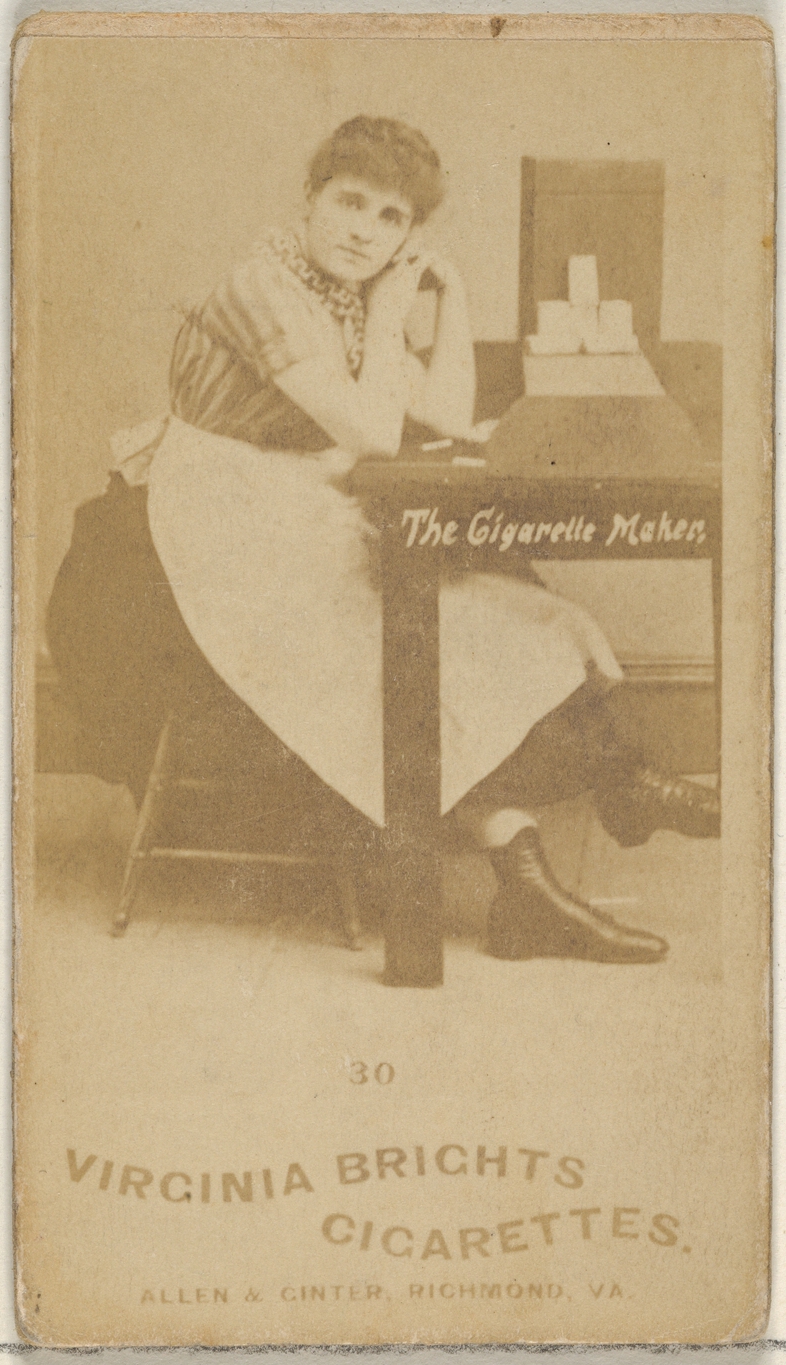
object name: photograph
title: Card 30, from the series, Cigarette Making Girls (N46) for Virginia Brights Cigarettes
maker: allen & ginter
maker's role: publisher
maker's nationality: american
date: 1888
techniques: albumen silver print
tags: girls,portraits